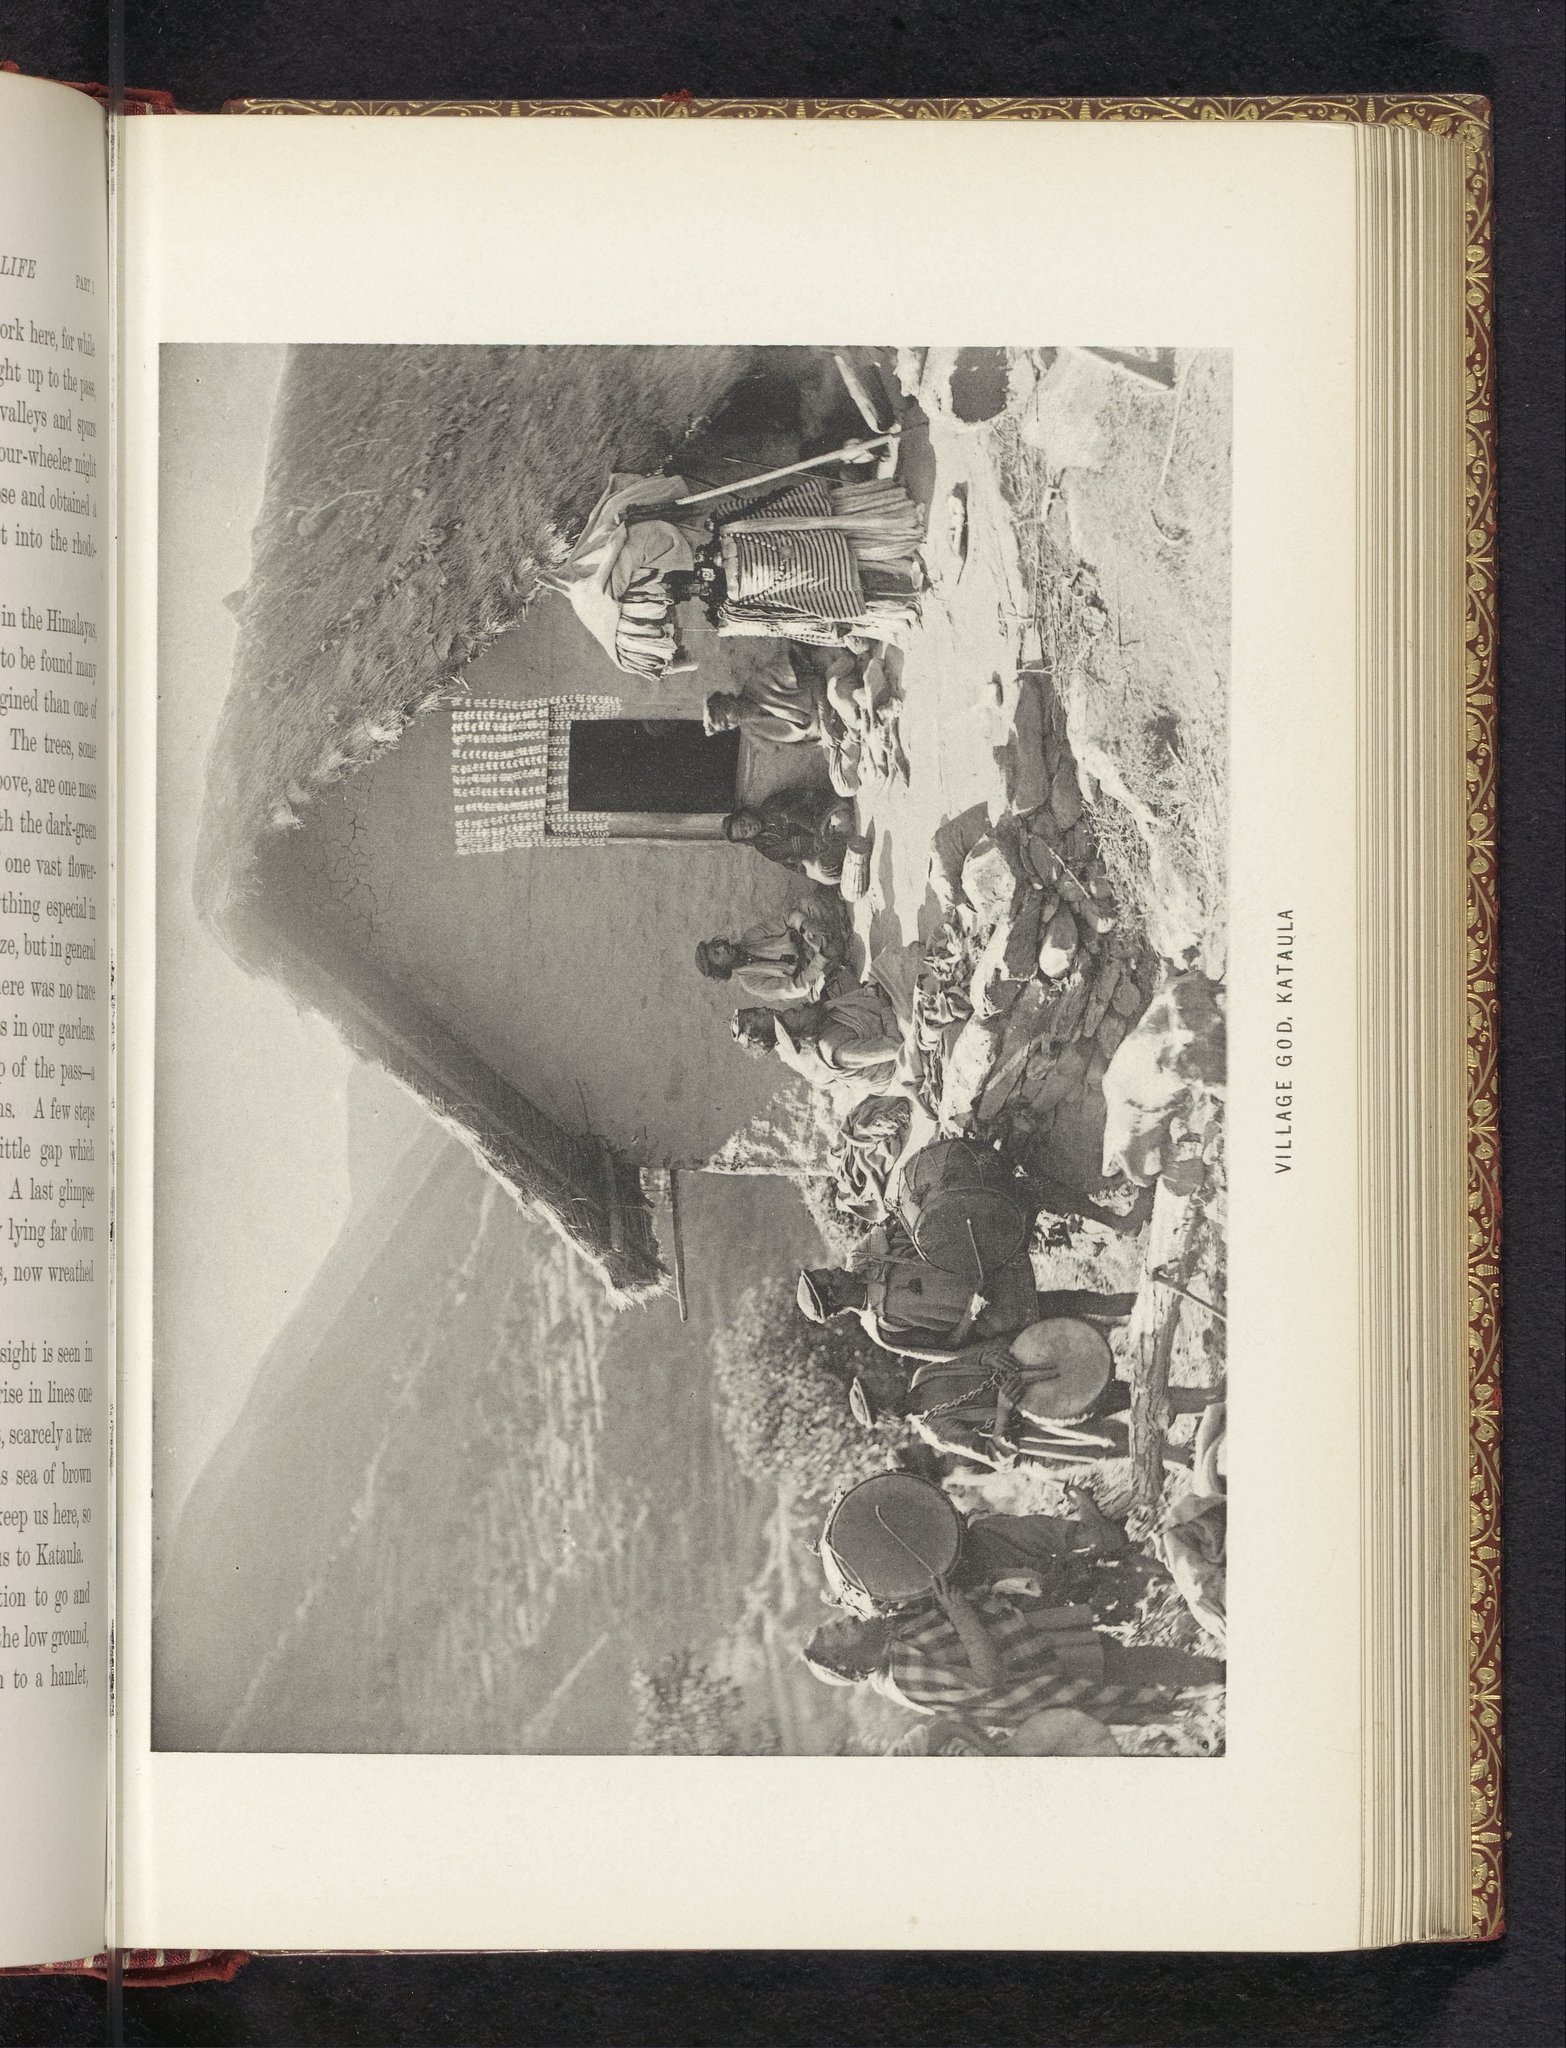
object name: page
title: Gathering of residents at an altar in Kataula, Himachal Pradesh, India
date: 1890-1895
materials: paper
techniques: photograph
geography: kataula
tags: altar ~ non-christian religions - bb - in the open air, façade (of house or building), drum (musical instrument) - cc - out of doors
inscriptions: caption: ‘VILLAGE GOD, KATAULA’